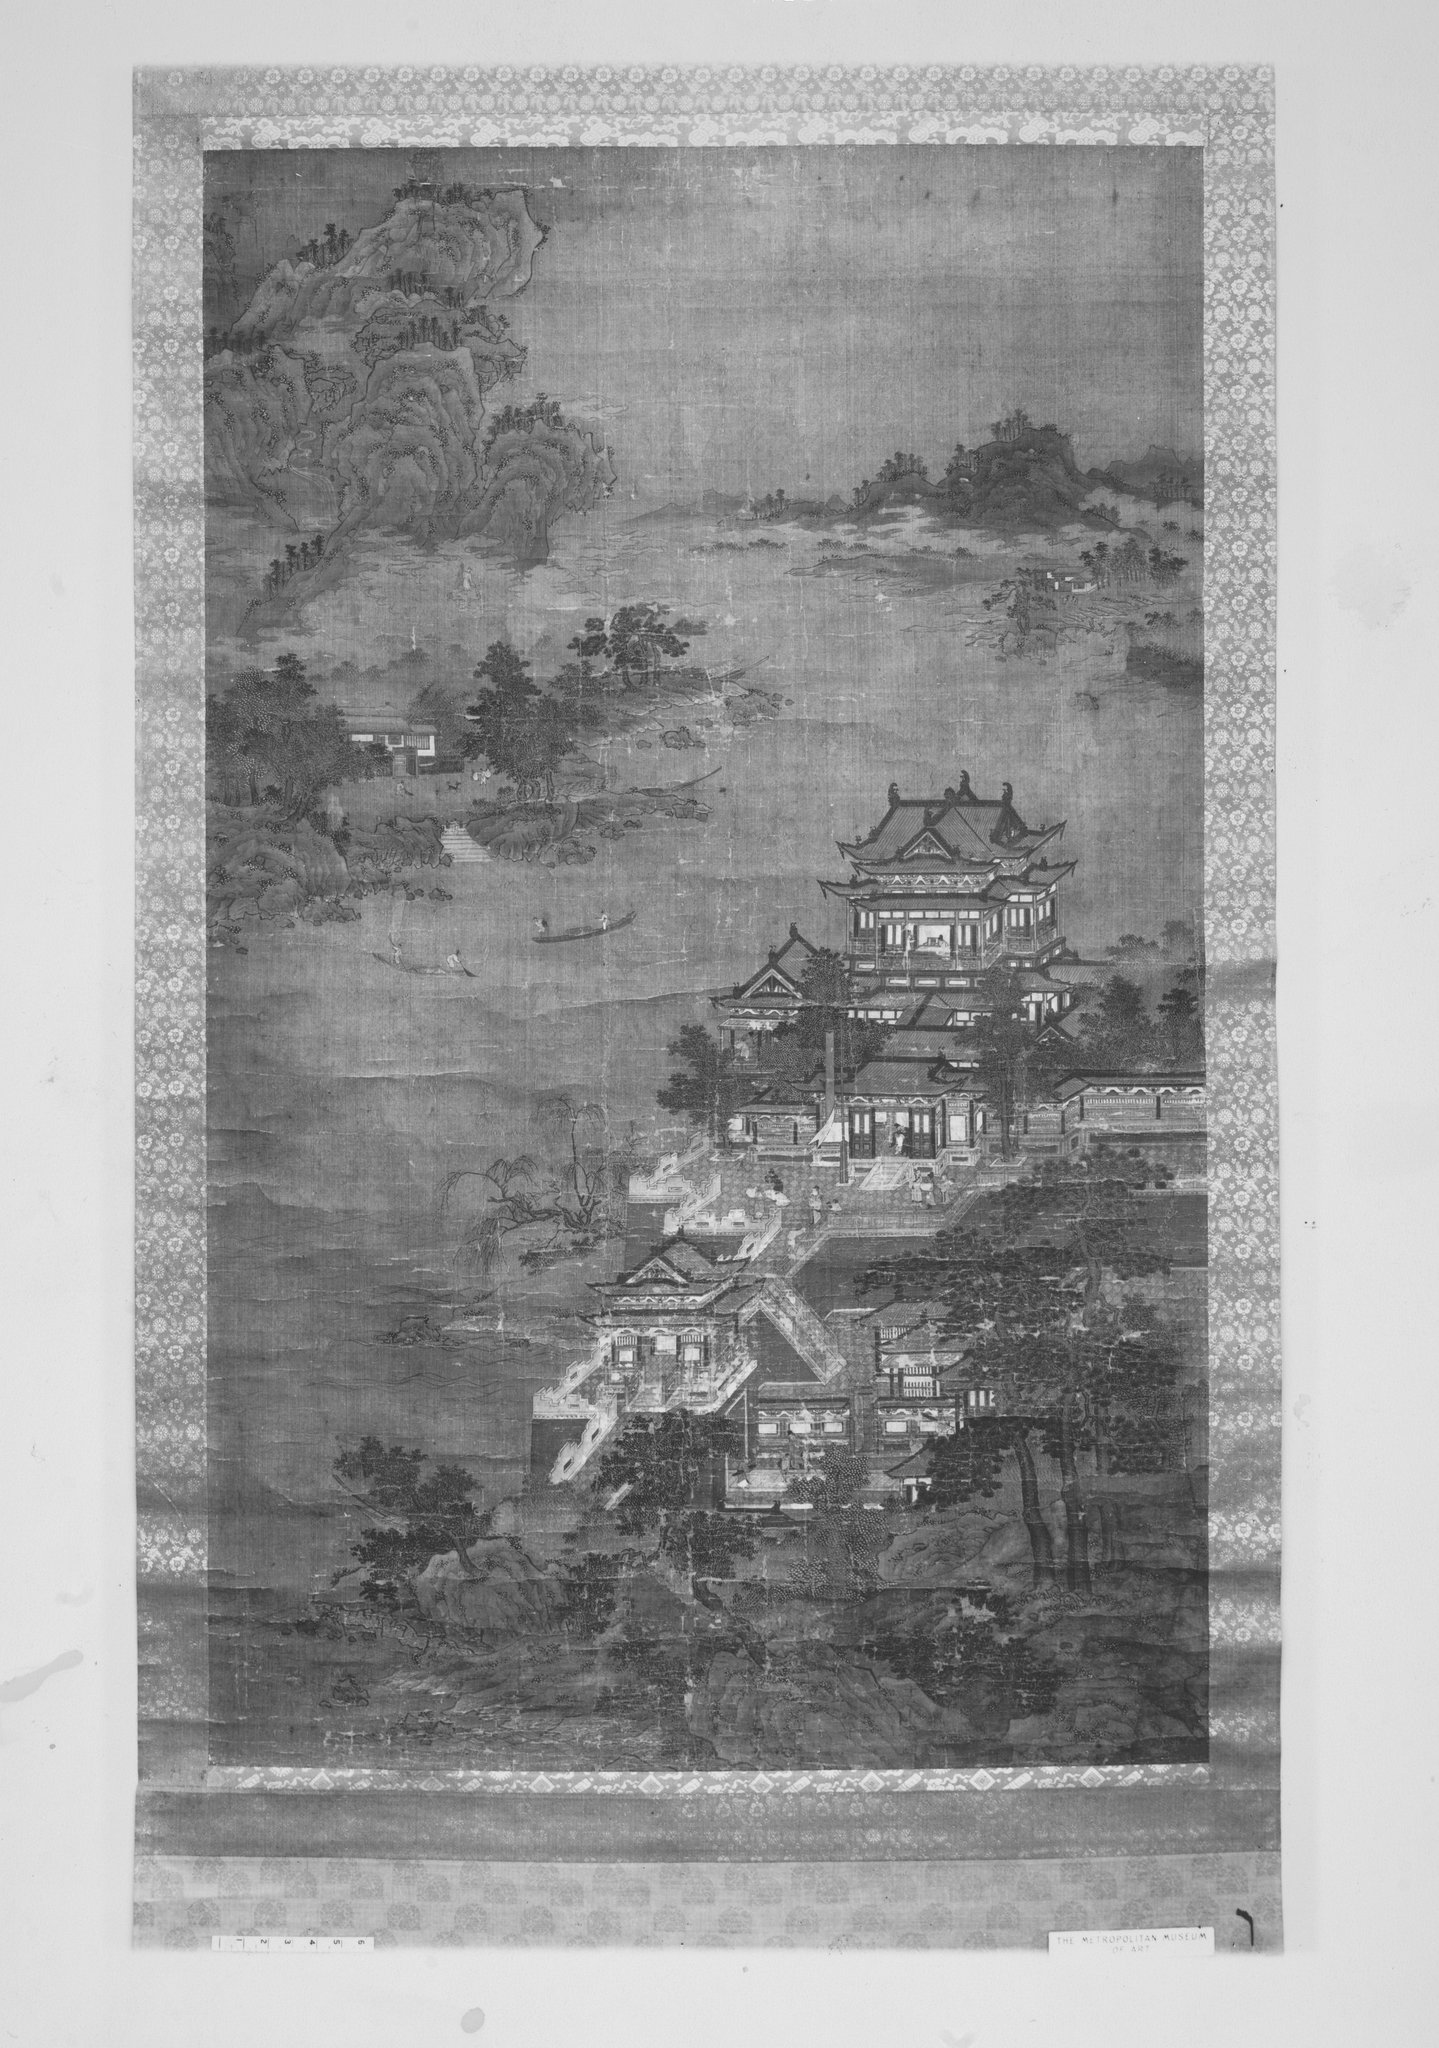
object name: hanging scroll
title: Landscape with Palace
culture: chinese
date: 1644-1911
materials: ink, silk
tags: palaces,landscapes